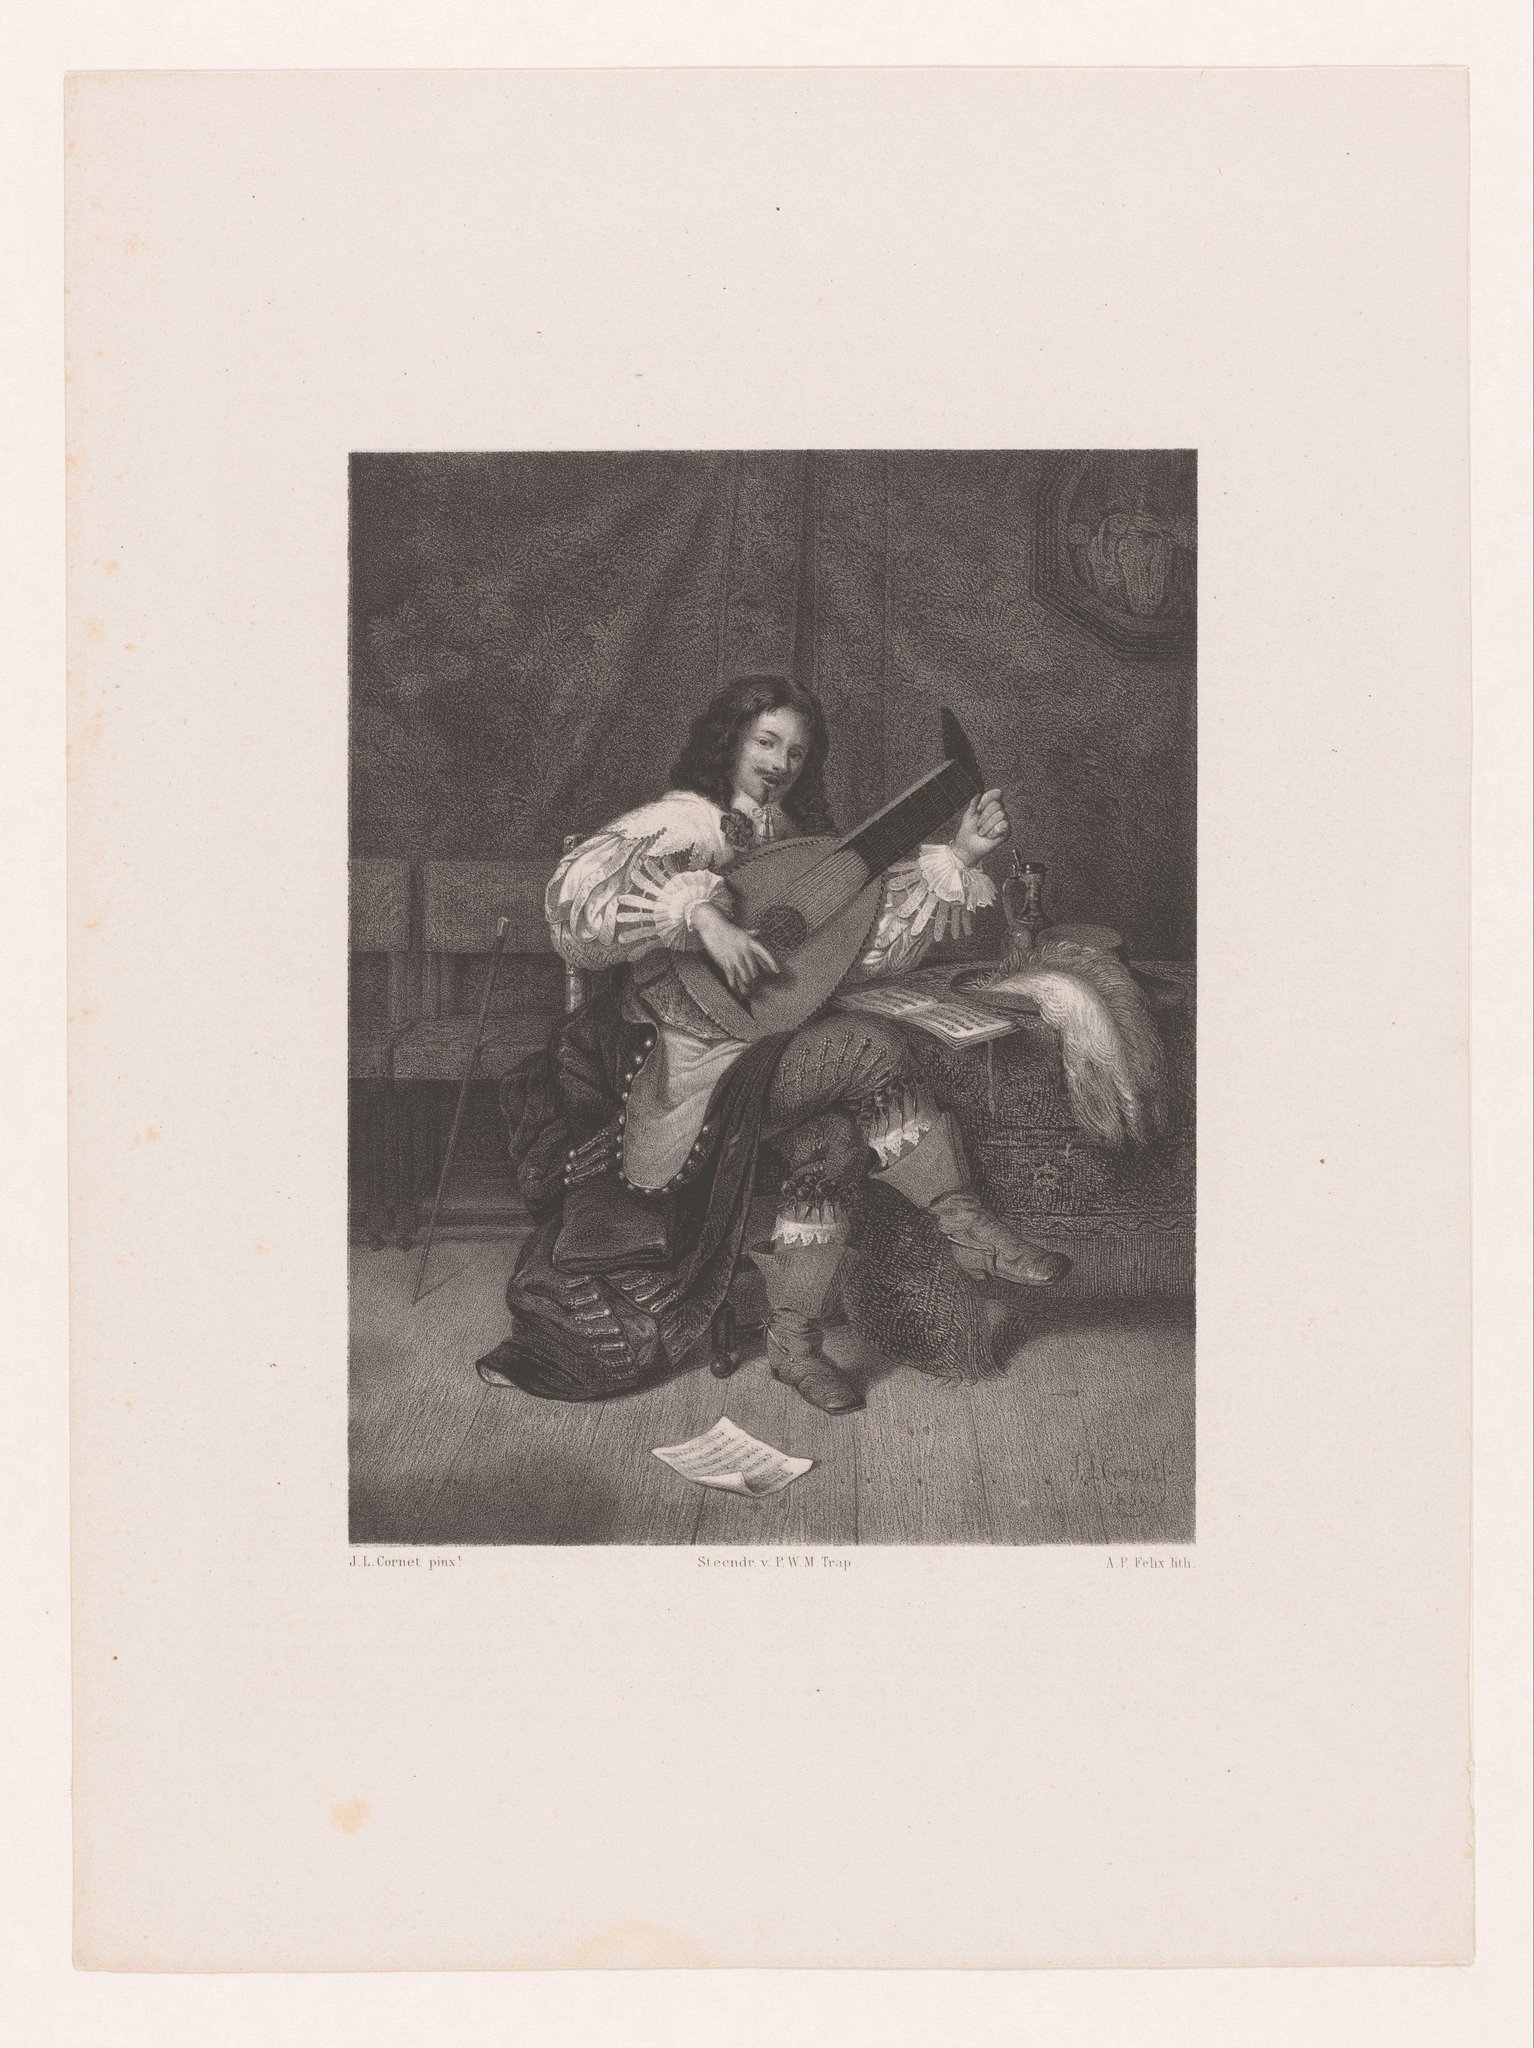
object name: print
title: Zingende man met luit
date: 1859-1900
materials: paper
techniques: lithograph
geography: leiden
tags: vocal music, singing, printed edition of musical score, lute, and special forms of lute, e.g.: theorbo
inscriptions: collector's mark: Lugt 2228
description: De man draagt een zeventiende-eeuws kostuum. Hij zit aan een tafel en heeft zijn jas uitgetrokken. Op de tafel en op de grond ligt bladmuziek.